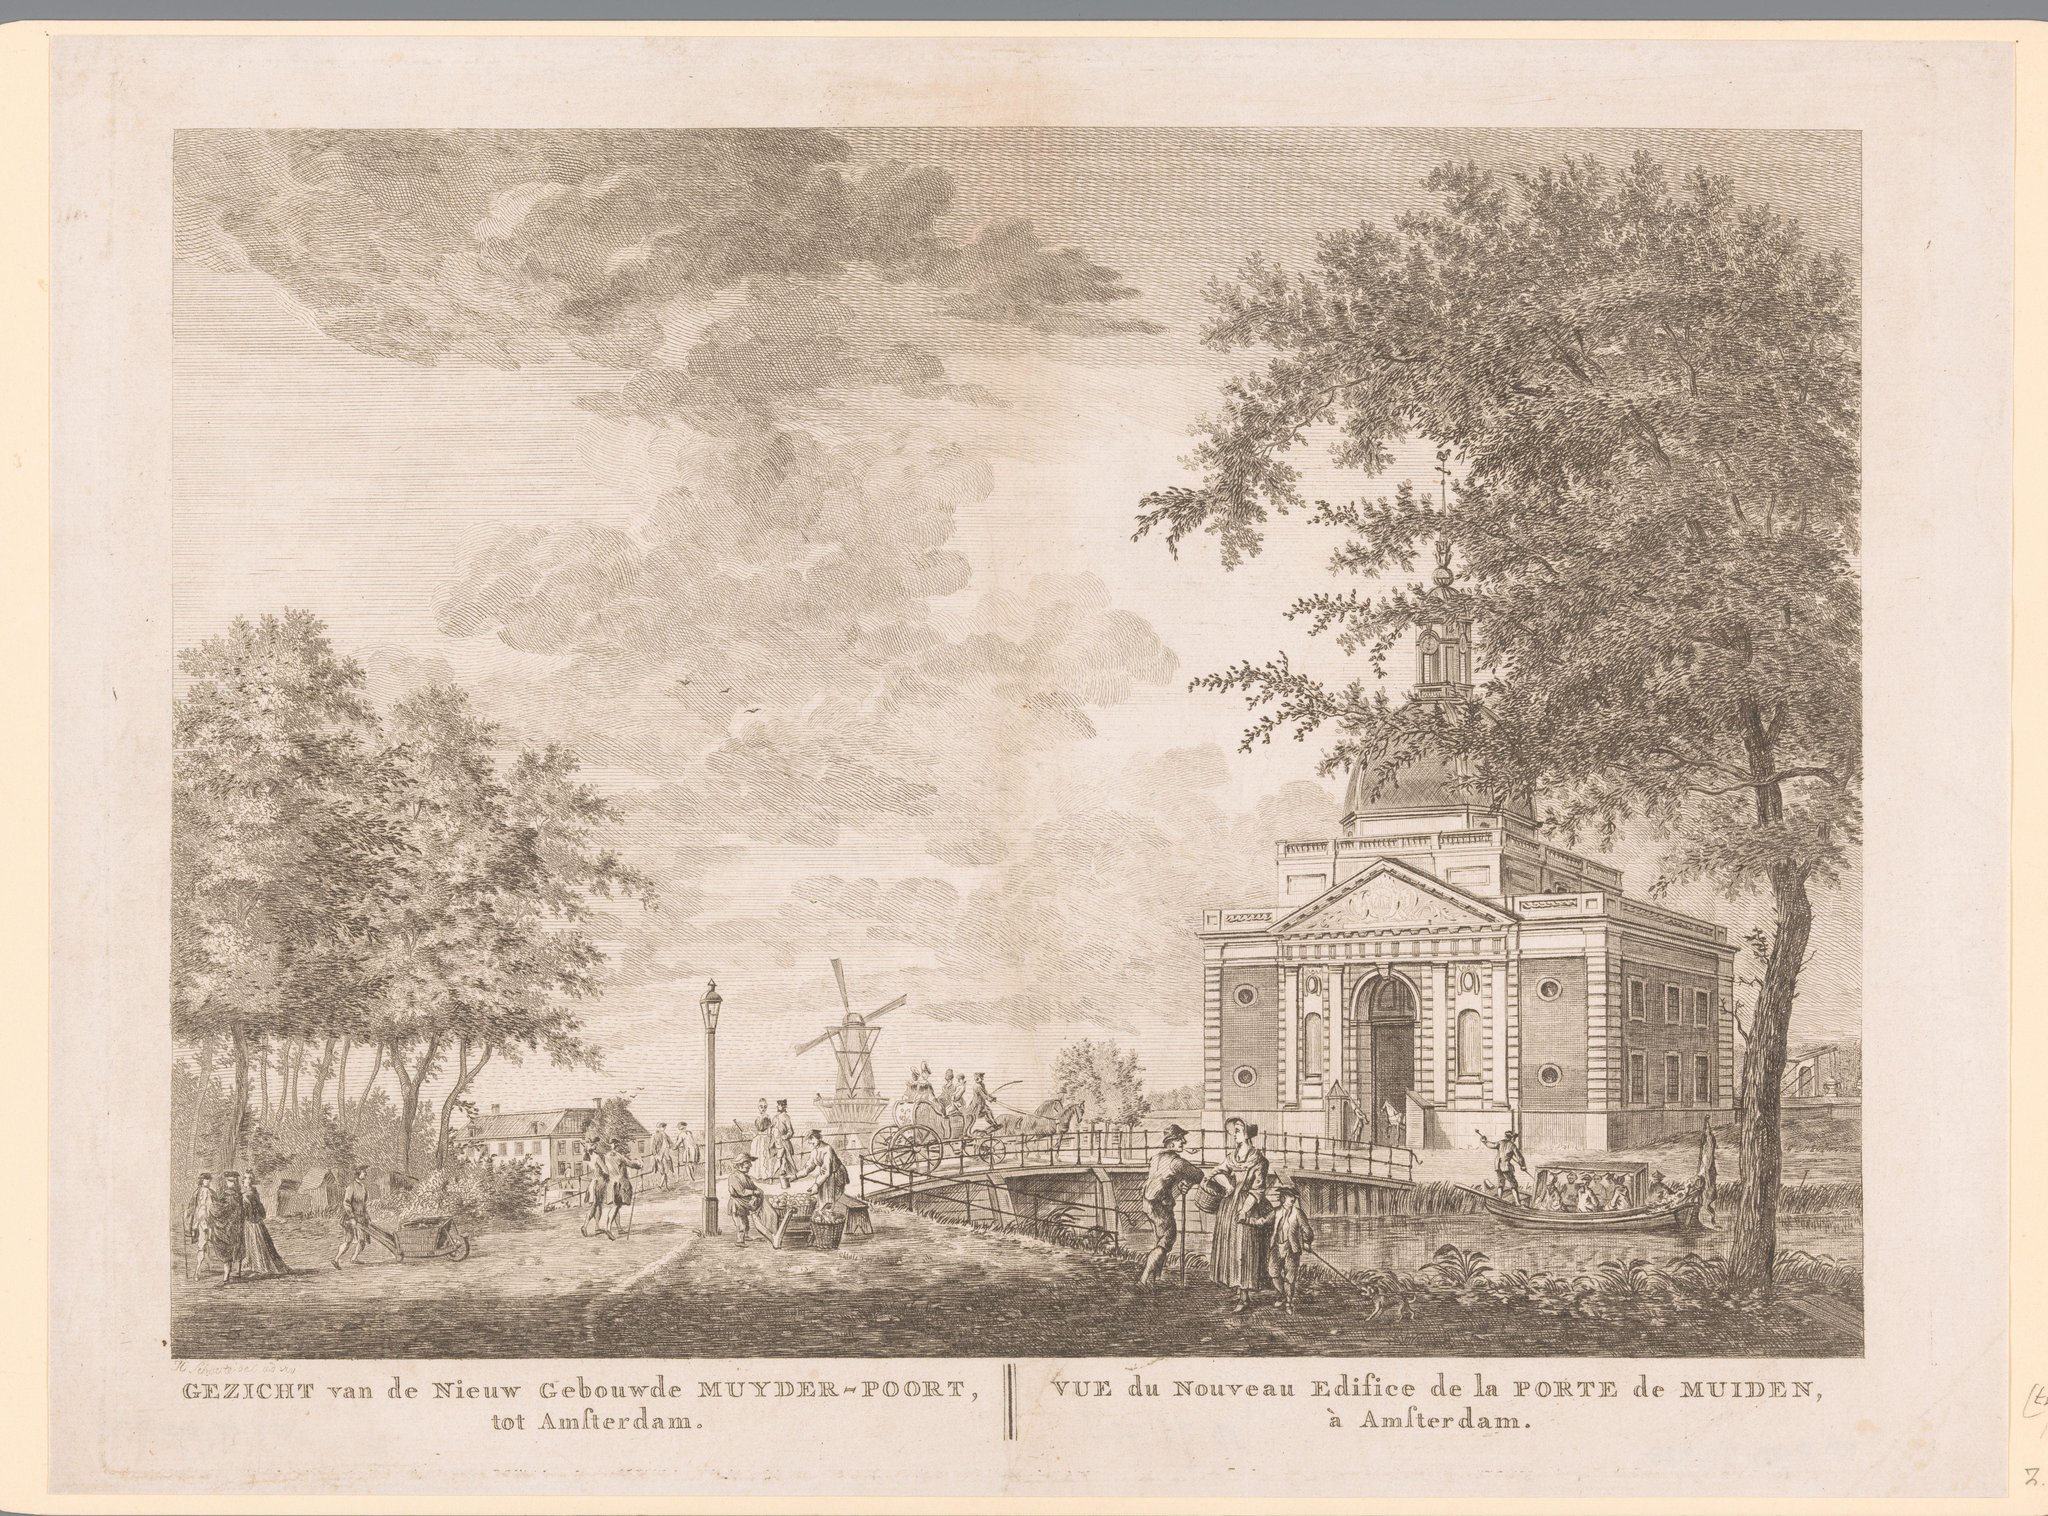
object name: book illustration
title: Gezicht op de Tweede Muiderpoort in Amsterdam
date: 1778-1783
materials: paper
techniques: engraving, etching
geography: amsterdam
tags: bridge in city across river, canal, etc., windmill, city-gate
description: Prent uit een van de volgende edities van de Atlas Fouquet: Afbeeldingen van de wyd-vermaarde koopstad Amsterdam benevens des zelvs voornaamste gebouwen en gezigten alle naar het leeven getekend / Receuil des edifices les plus considerables et des plus belles vues, de la fameuse ville d'Amsterdam, dessinées d'après nature. Amsterdam: Pierre Fouquet, 1778-1783. Nieuwe atlas, van de voornaamste gebouwen en gezigten der stad Amsterdam, met derzelver beknopte beschryvingen. 2 dln. Amsterdam: Daniël Jean Changuion en Petrus den Hengst [in opdracht van Pierre Fouquet], 1783. Nieuwe atlas, van de voornaamste gebouwen en gezigten der stad Amsterdam. Met derzelver beknopte beschryvingen. Amsterdam: Evert Maaskamp, 1805.